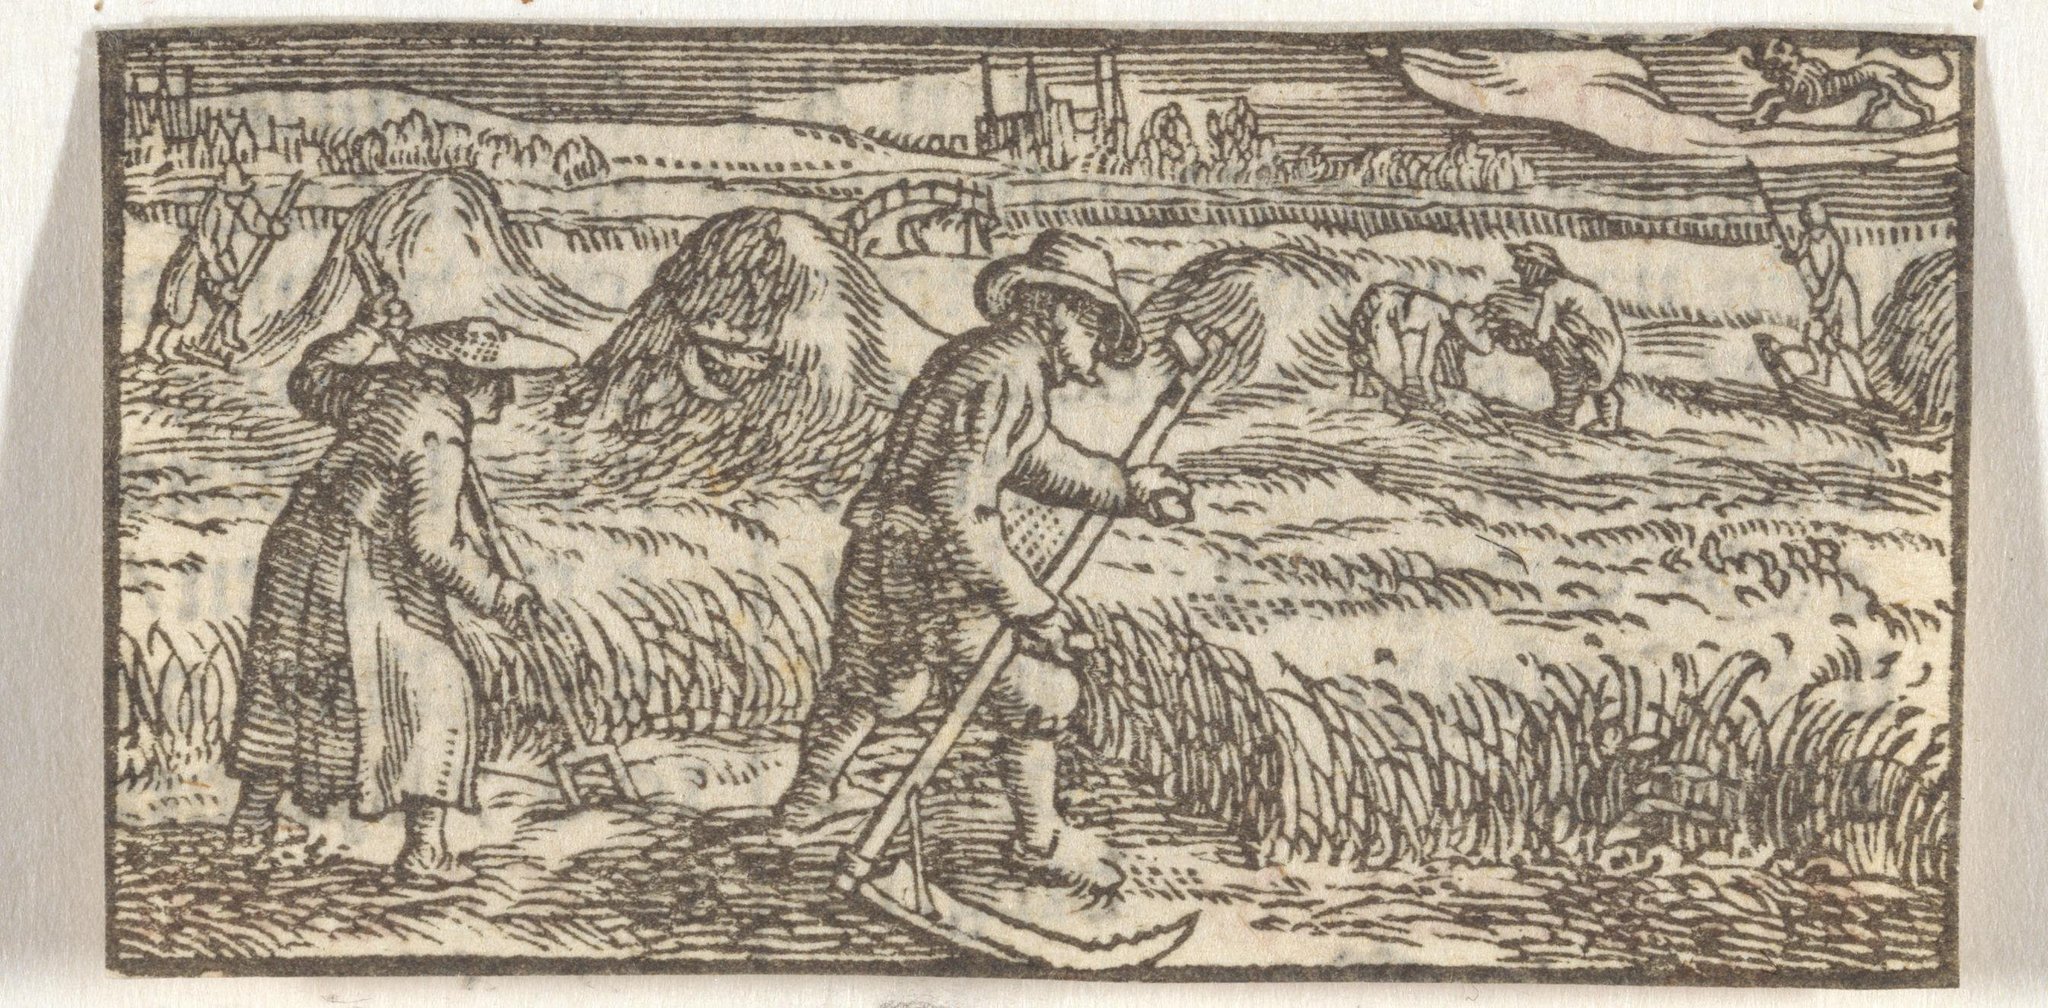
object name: book illustration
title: Maanden van het jaar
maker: Anonymous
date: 1600-1699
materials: paper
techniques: letterpress printing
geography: netherlands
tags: harvest, july and its 'labours' (+ with leo (july)), reaping, picking, mowing ~ harvest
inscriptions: collector's mark: Lugt 2228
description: Hooiers en een maaier werkend op het land. Rechtsboven een leeuw.